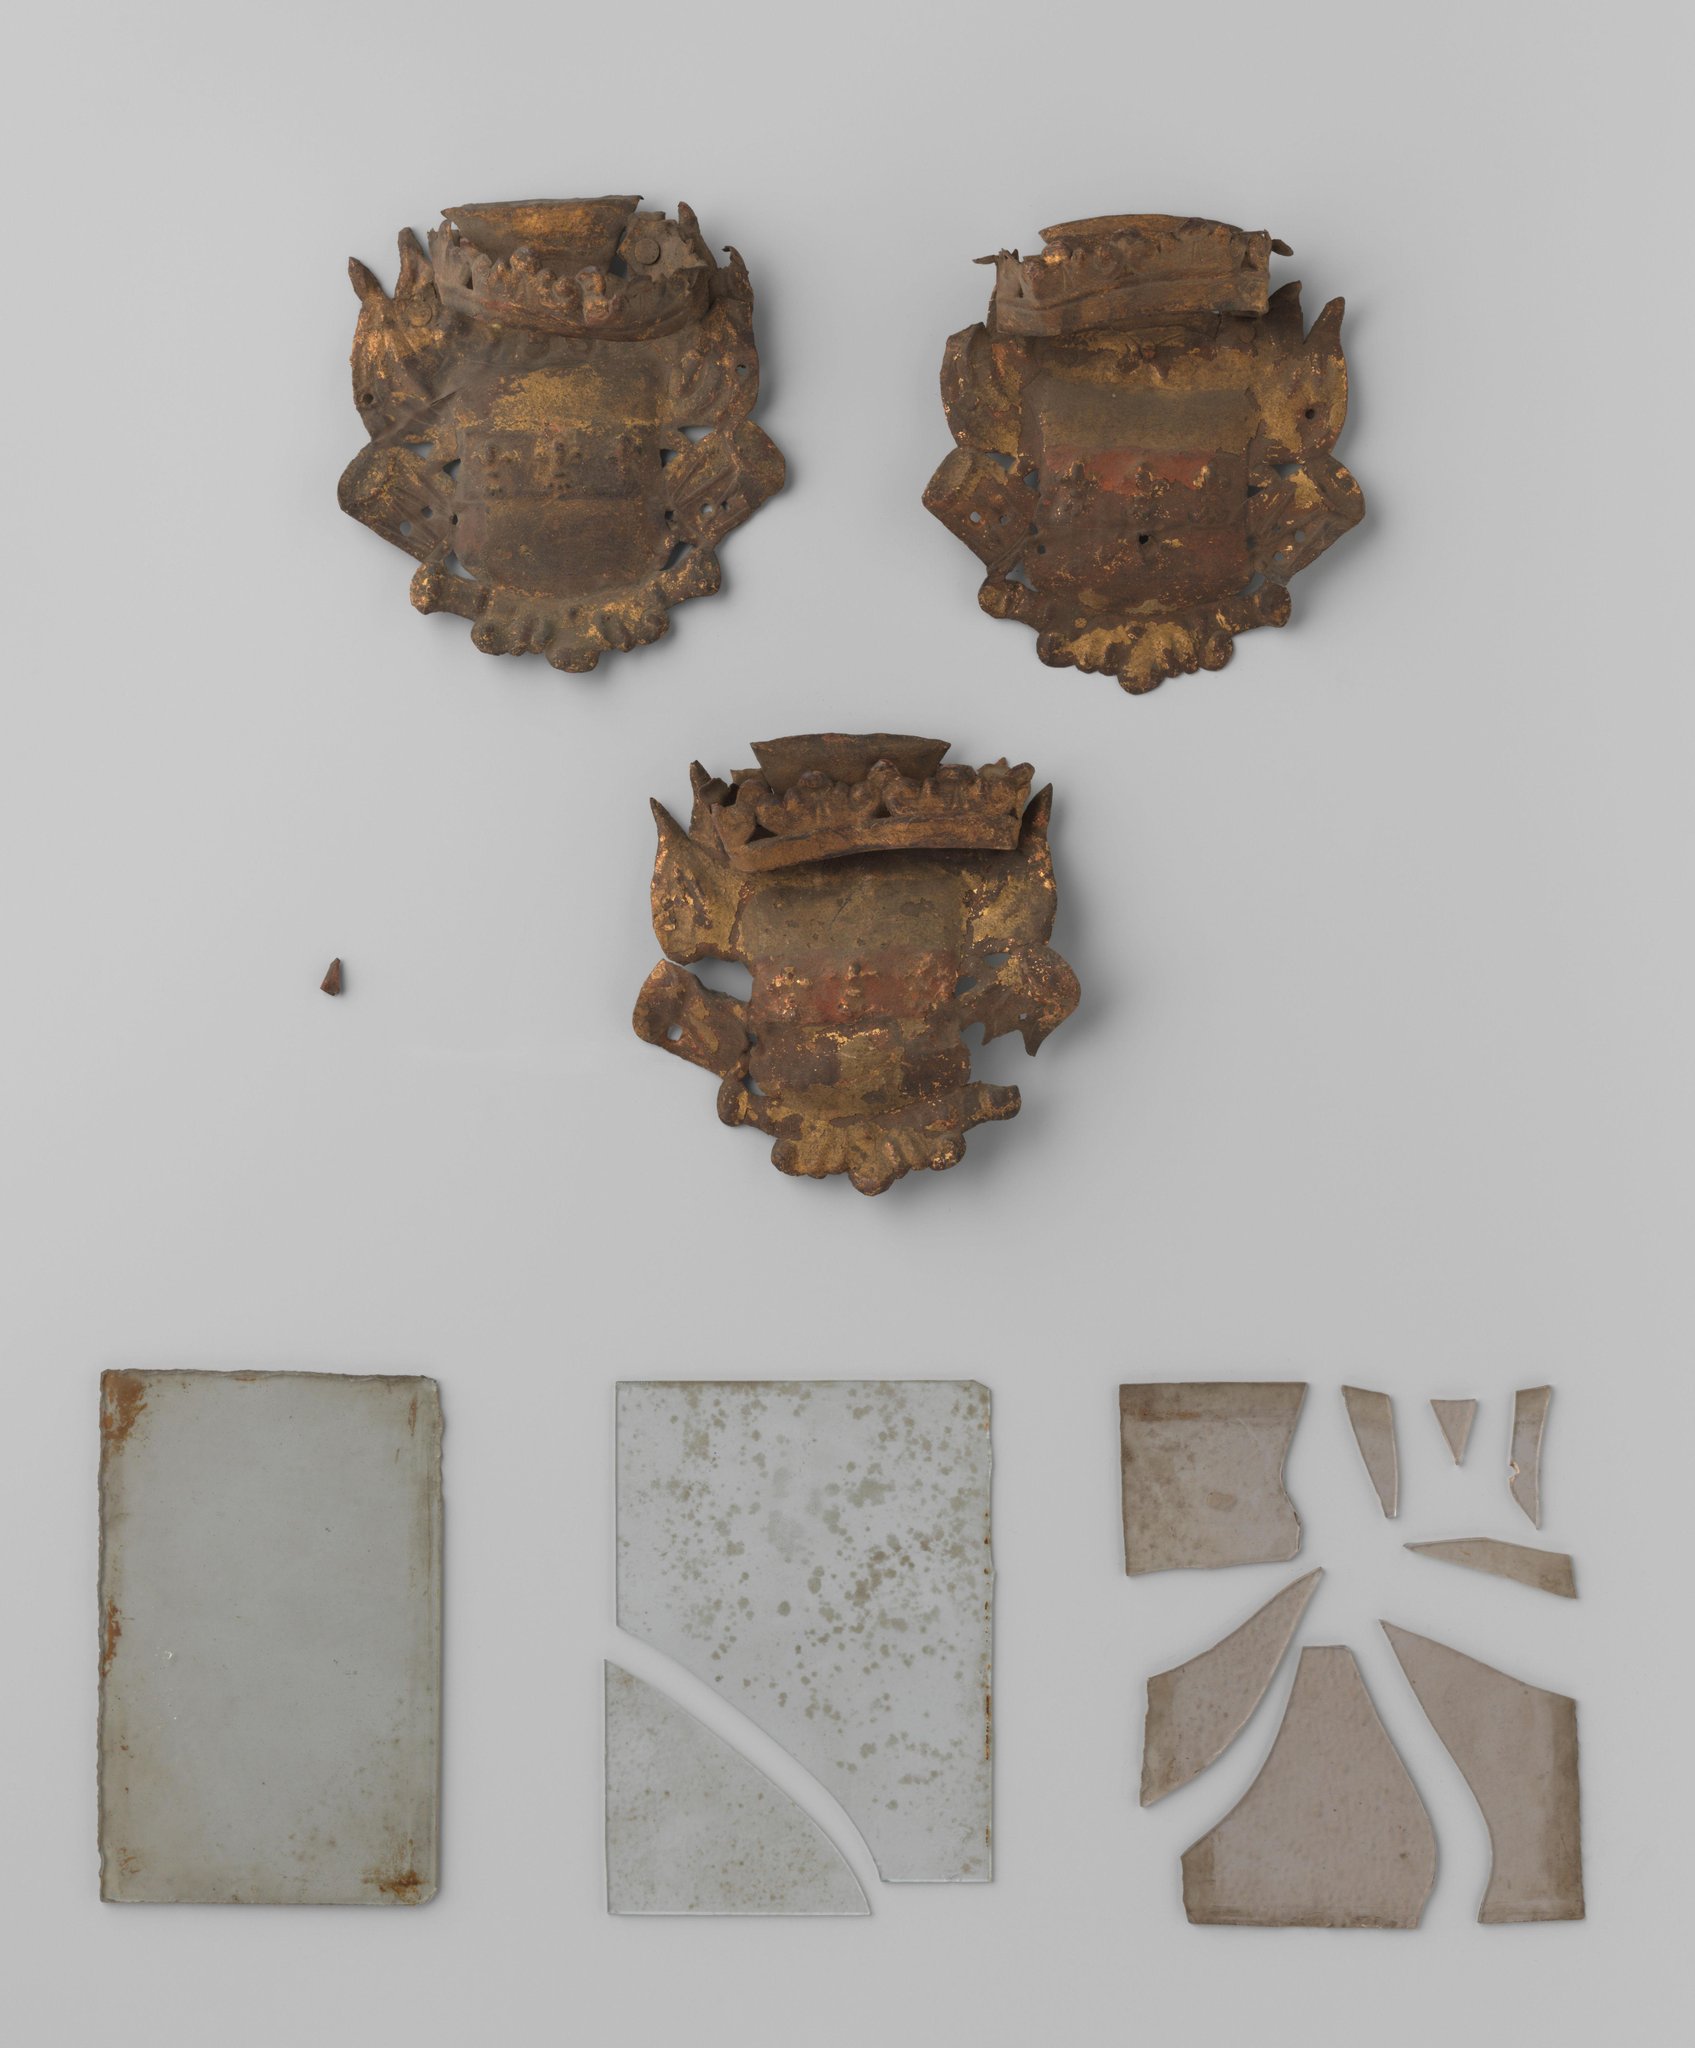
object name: lantern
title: Afgebroken wapenschilden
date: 1700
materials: iron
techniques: gilding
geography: venice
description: Twee wapenschilden en een ornament van de lantaarn, zeszijdig middendeel van naar binnen gebogen stijlen, met koepelvormig geleed dak. Wapens boven de vensters.